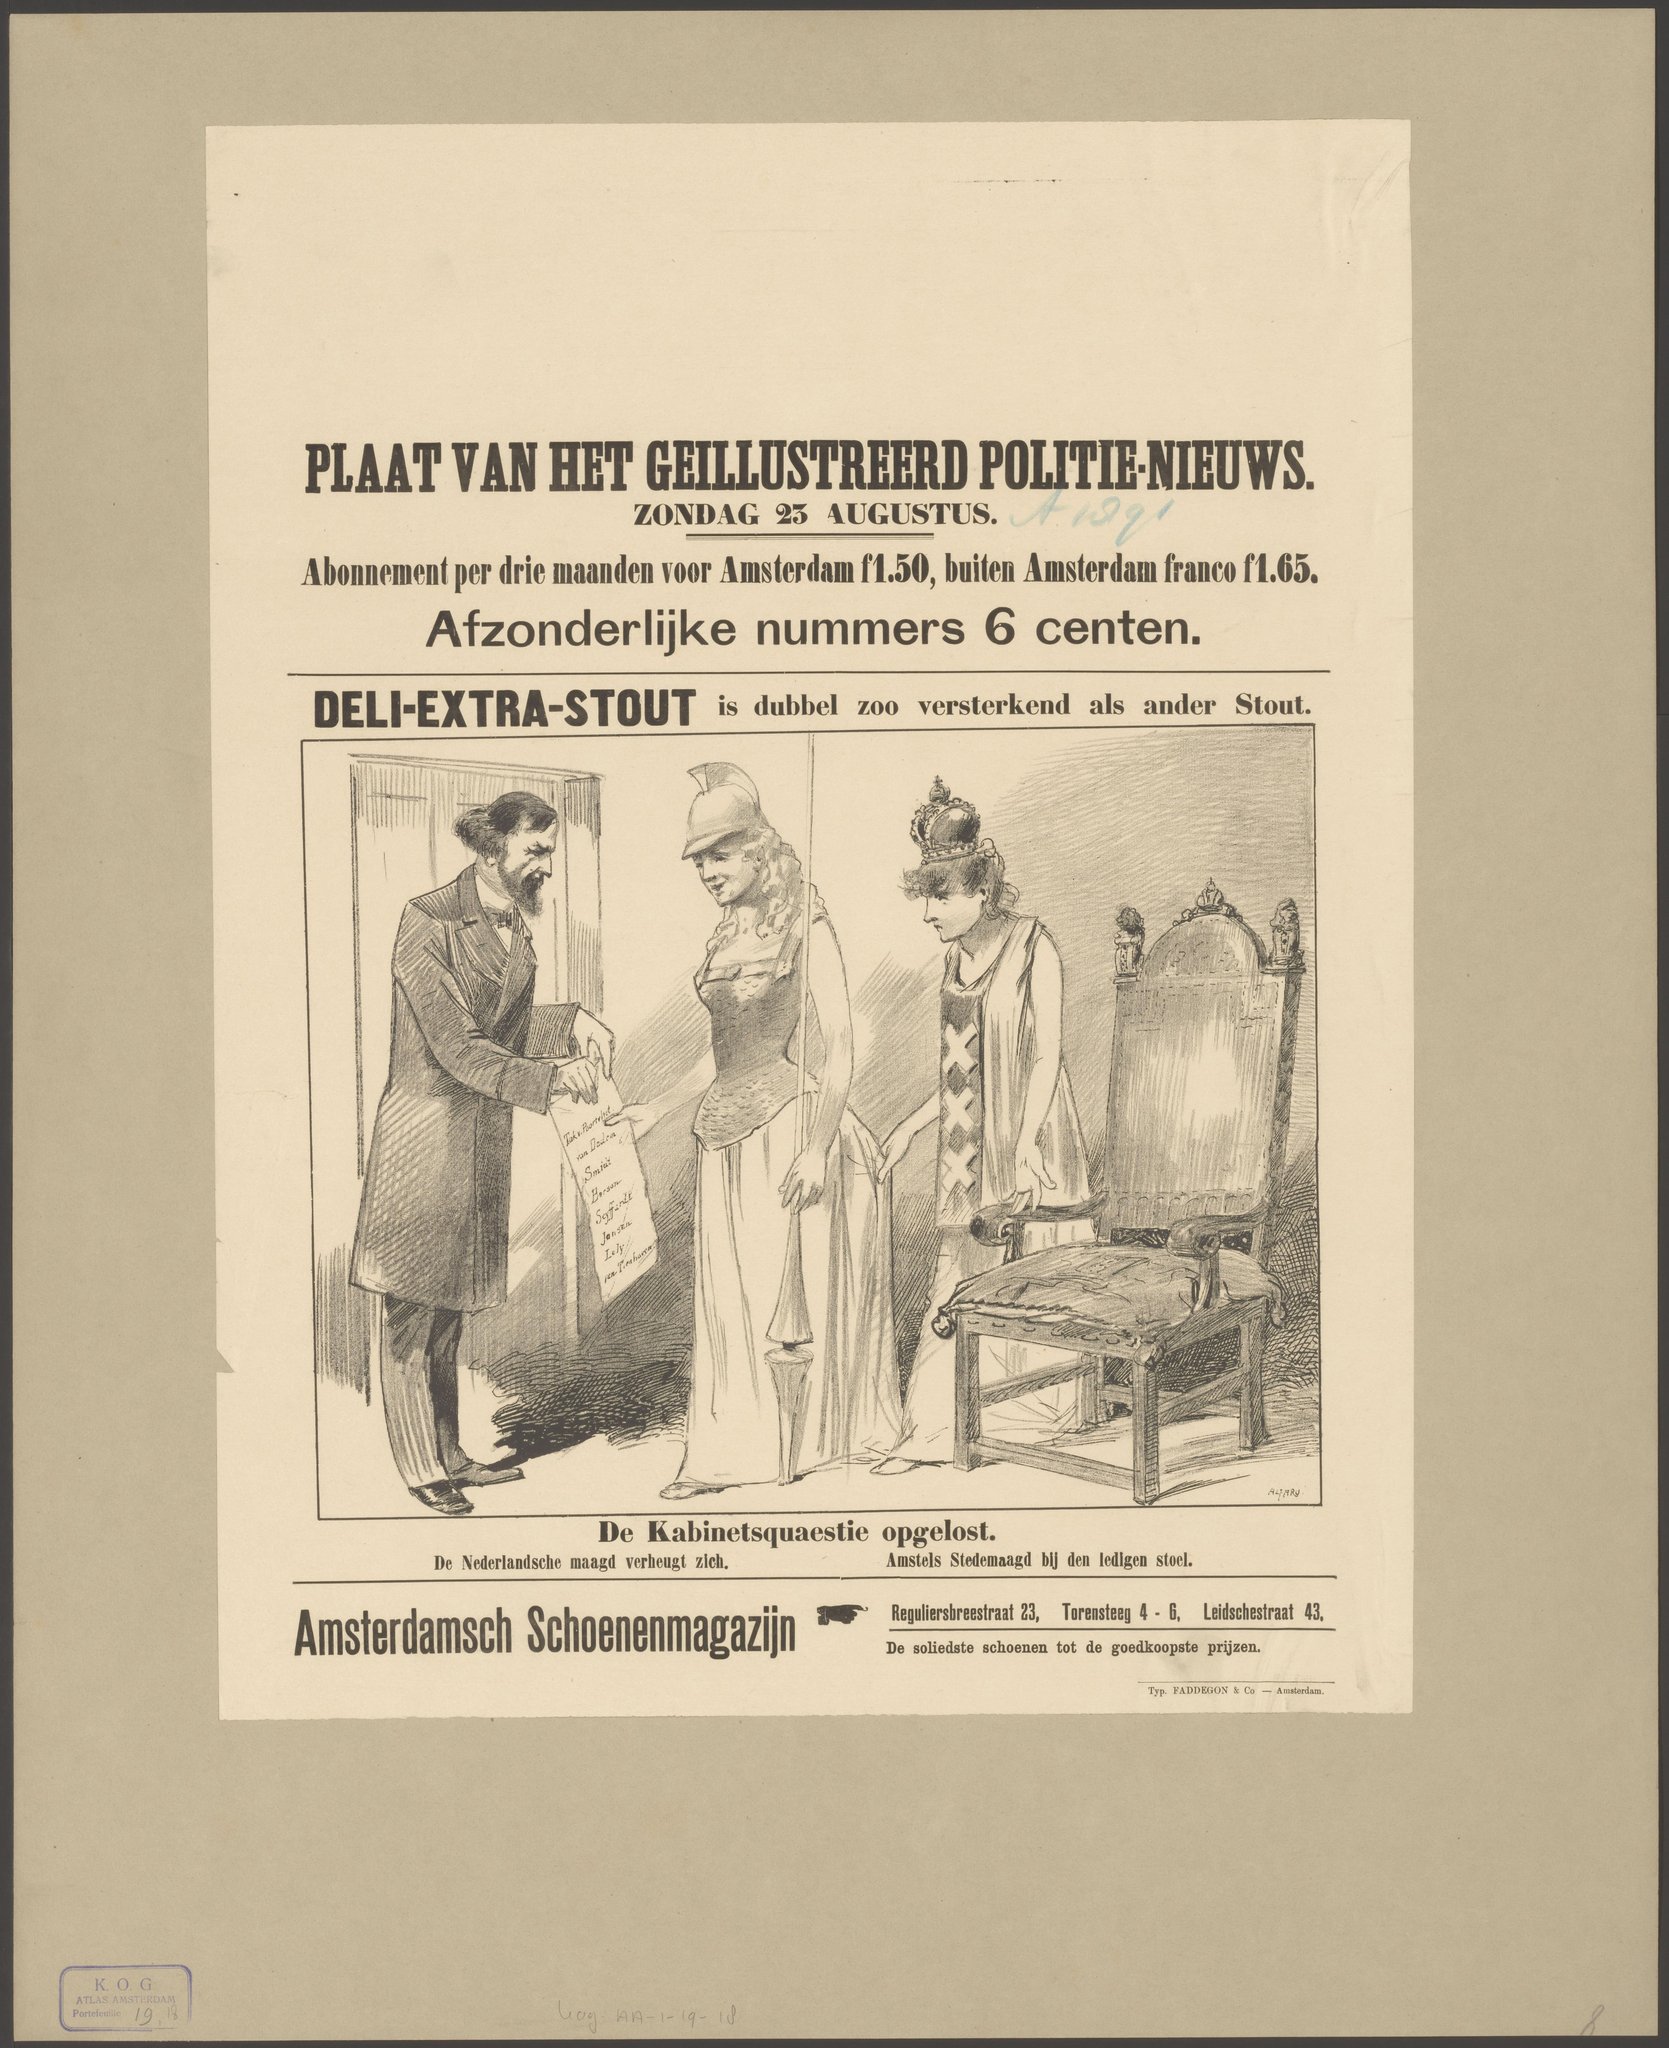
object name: cartoon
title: De Kabinetsquaestie opgelost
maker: alfaro reijding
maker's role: draughtsman, engineer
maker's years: 1863-1930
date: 1891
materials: paper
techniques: letterpress printing, lithograph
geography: amsterdam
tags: prime minister, political caricatures and satires, amsterdam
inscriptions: collector's mark: ‘19,18’ Lugt 1641b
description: Onderwerpsrubriek binnen de Atlas Amsterdam: Herinneringen aan regeringsleden en hunne huisgezinnen [na 1800].